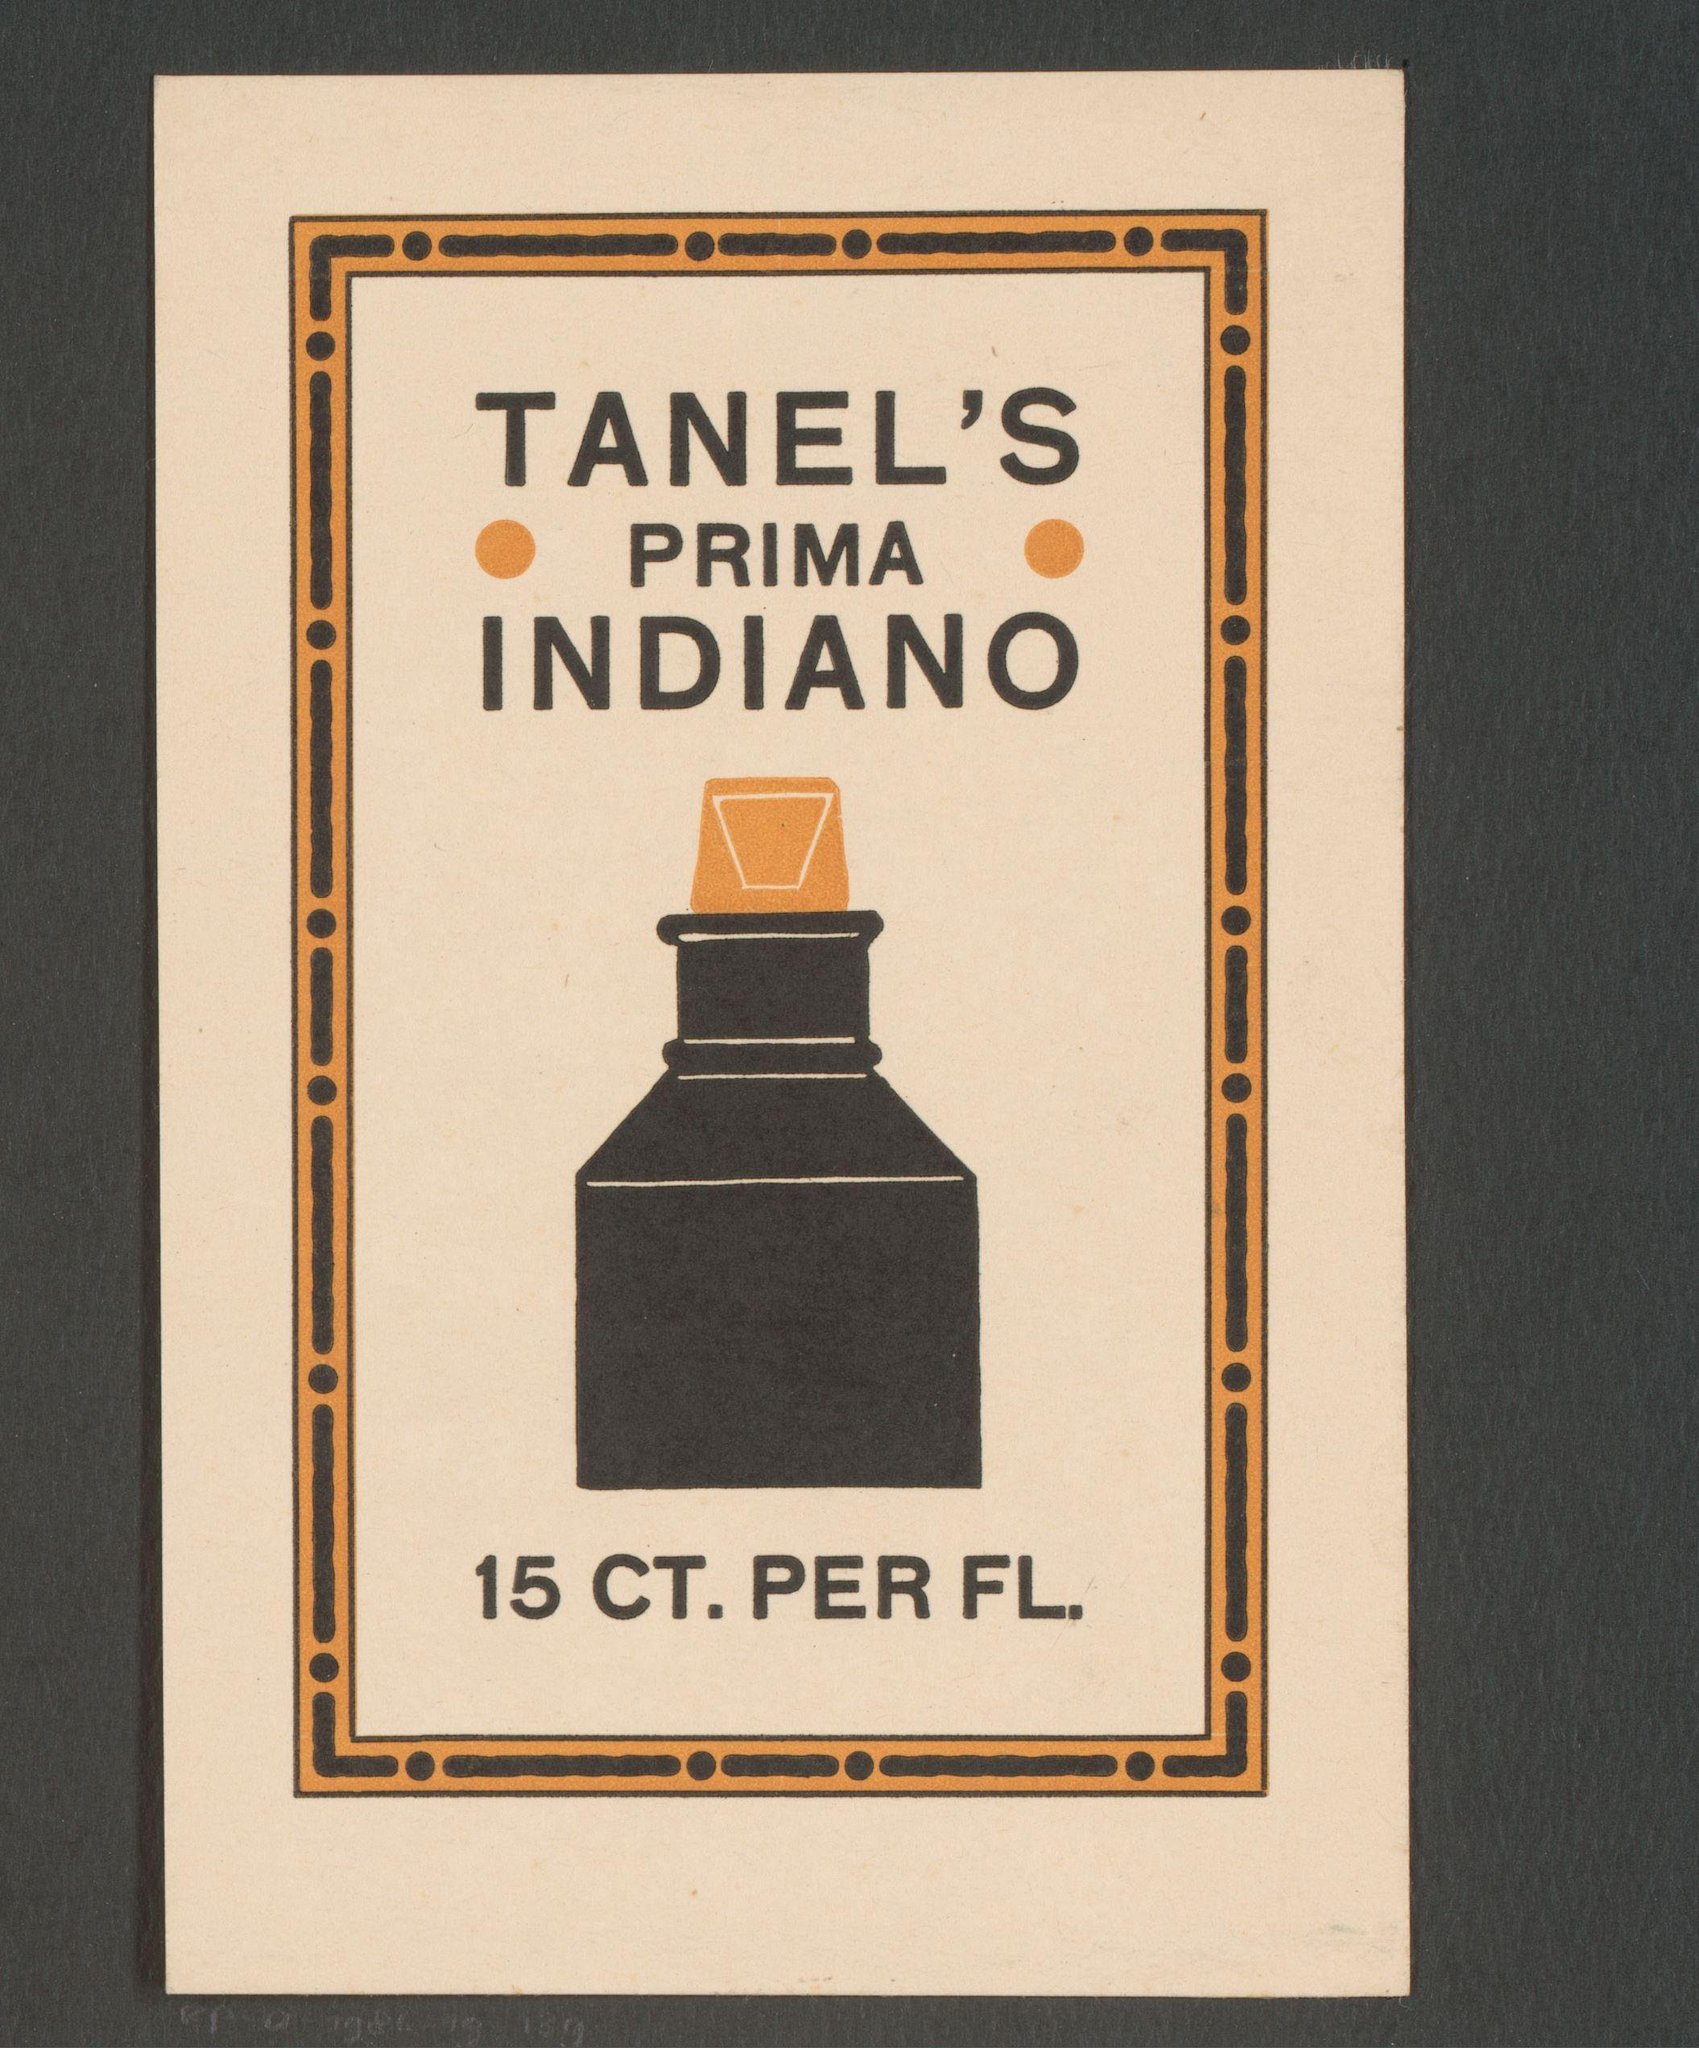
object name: photomechanical print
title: Advertentie voor Tanel's Prima Indiano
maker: reinier willem petrus de vries (1874-1953)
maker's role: draughtsman, print maker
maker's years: 1874-1953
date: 1884-1952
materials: paper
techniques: printing block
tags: container of glass: bottle, jar, vase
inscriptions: collector's mark: ‘R:MVS.’